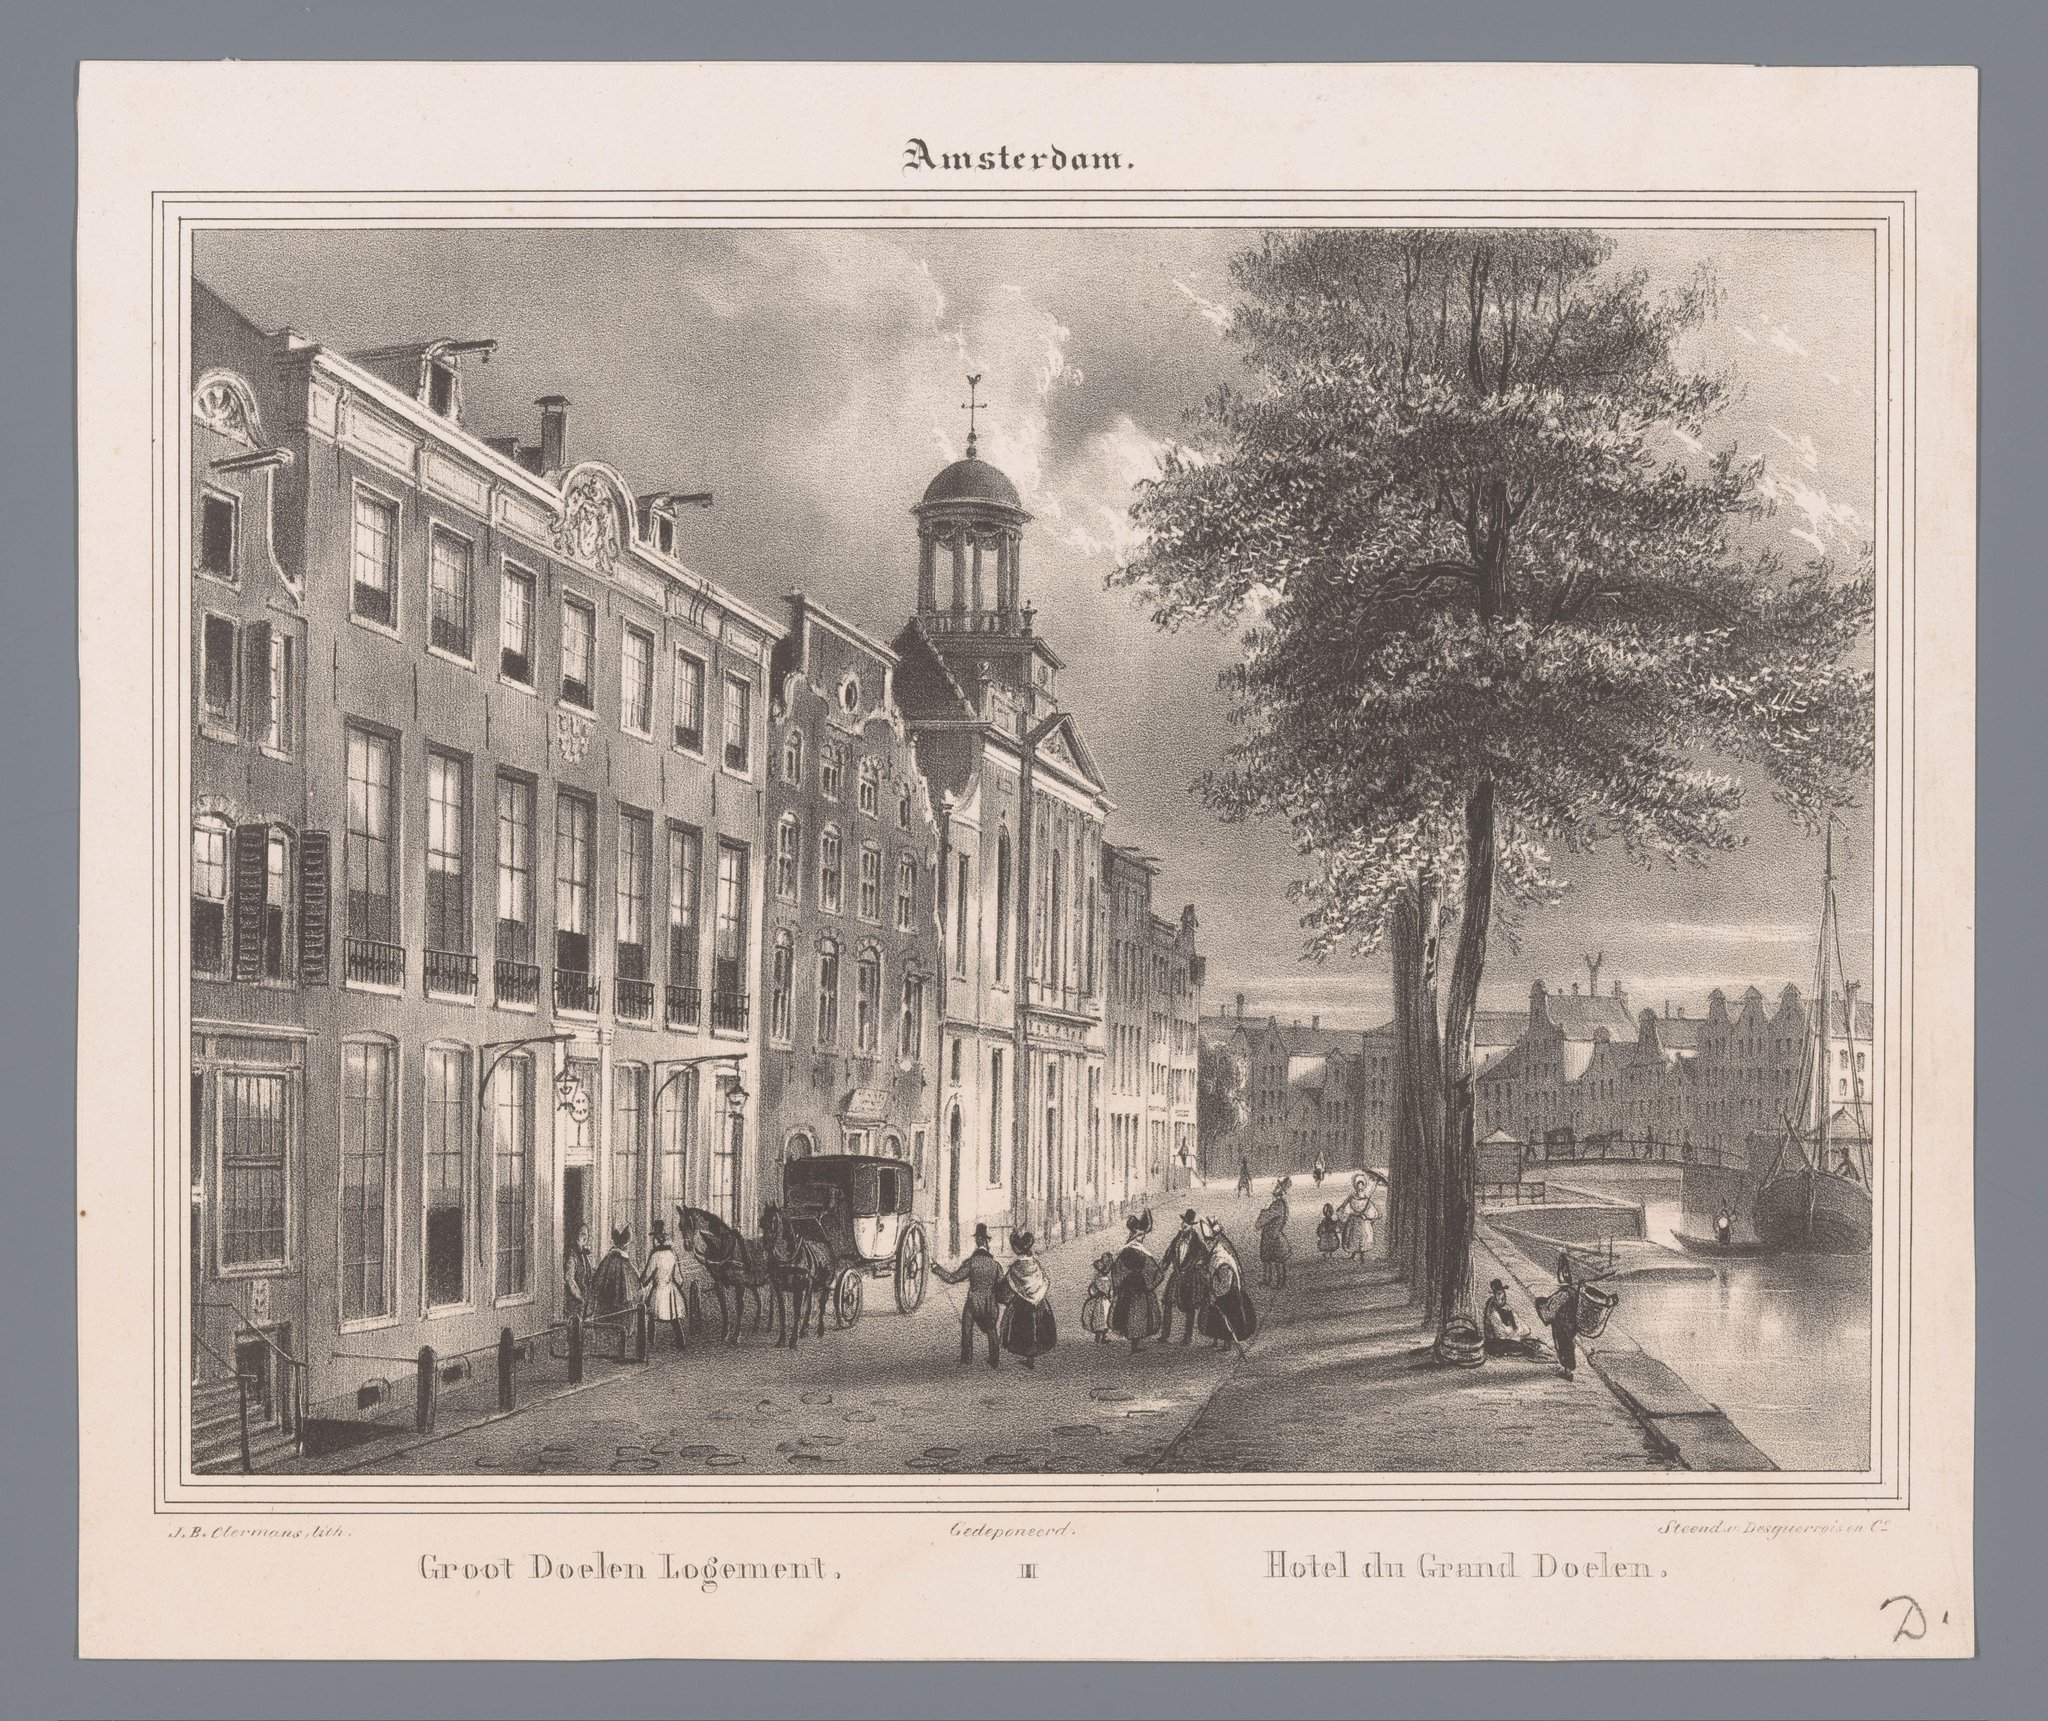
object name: print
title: Groot Doelen Logement / Hotel du Grand Doelen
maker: j.b. clermans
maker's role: print maker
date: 1826-1839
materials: paper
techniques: lithograph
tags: sailing-ship, sailing-boat, canals, waters (in city), four-wheeled vehicle drawn by two animals, hotel, hostelry, inn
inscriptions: collector's mark: Lugt 2760, collector's mark: Lugt 2228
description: Links aan het Singel, gezien in oostelijke richting, ligt het Groot Doelen Logement, tegenwoordig de Universiteitsbibliotheek. Rechts het huidige Koningsplein.